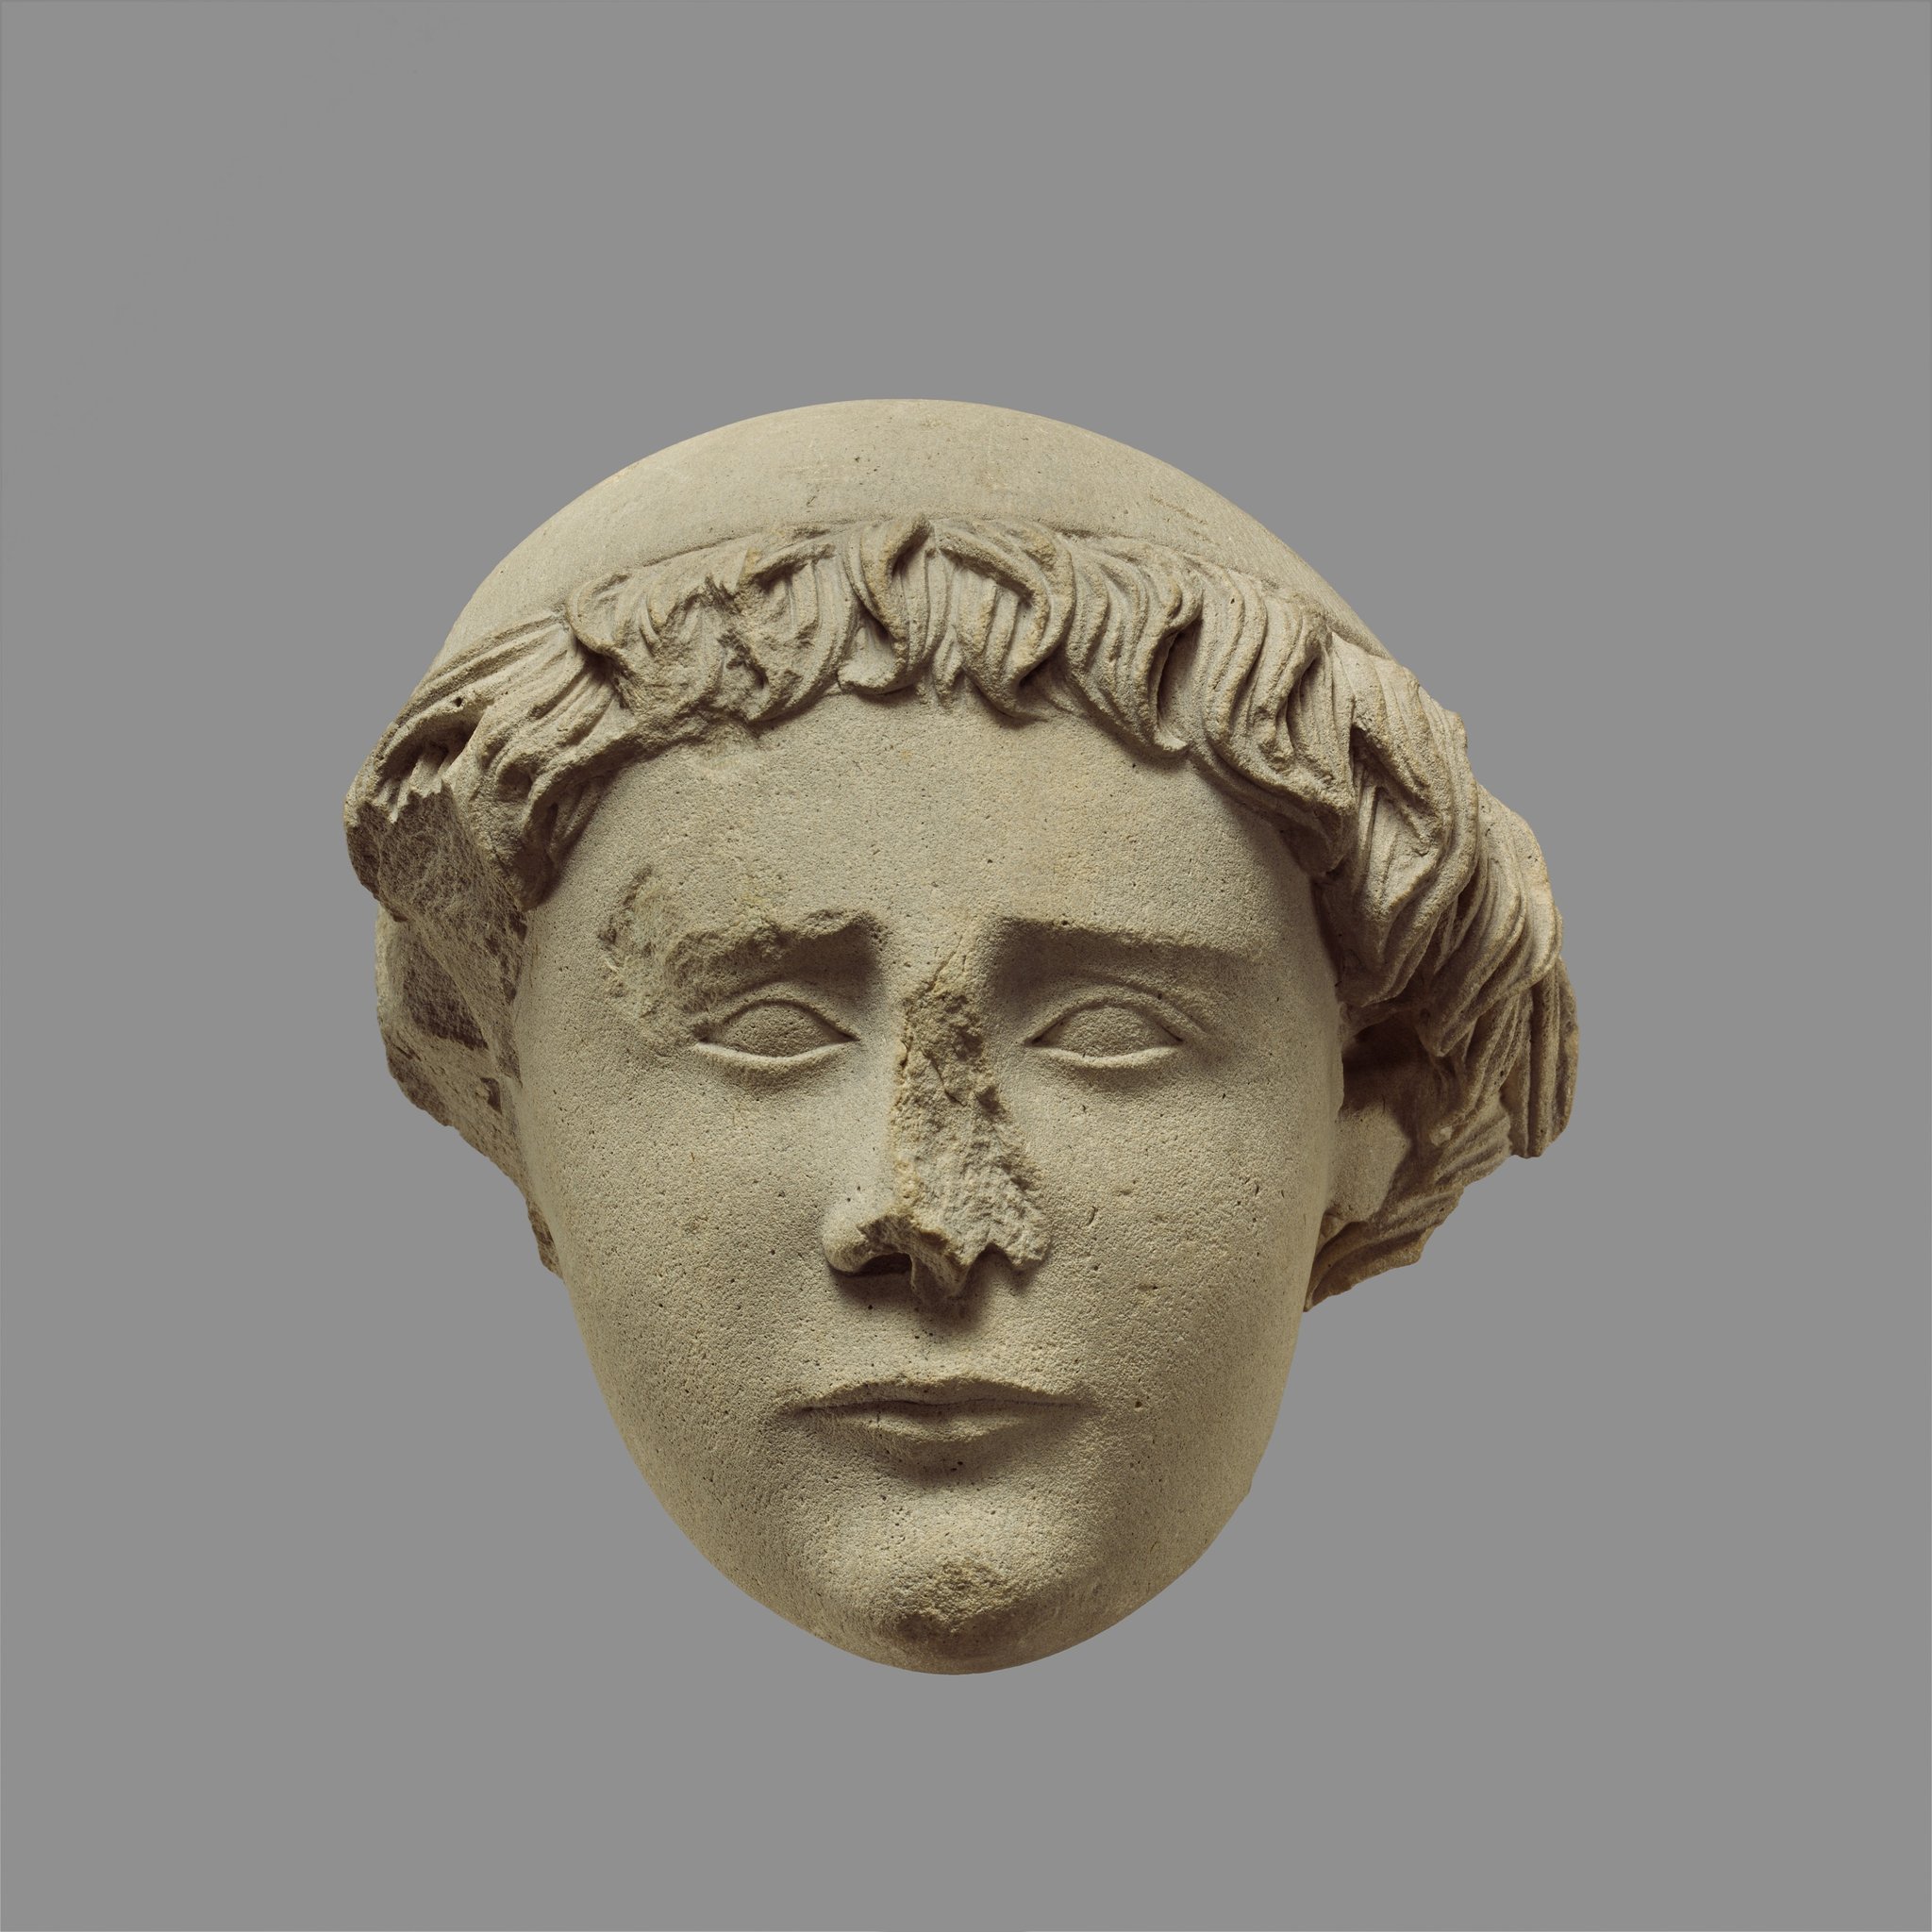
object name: statue head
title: Head of a Youth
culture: french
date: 1230-1250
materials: limestone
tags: heads,men